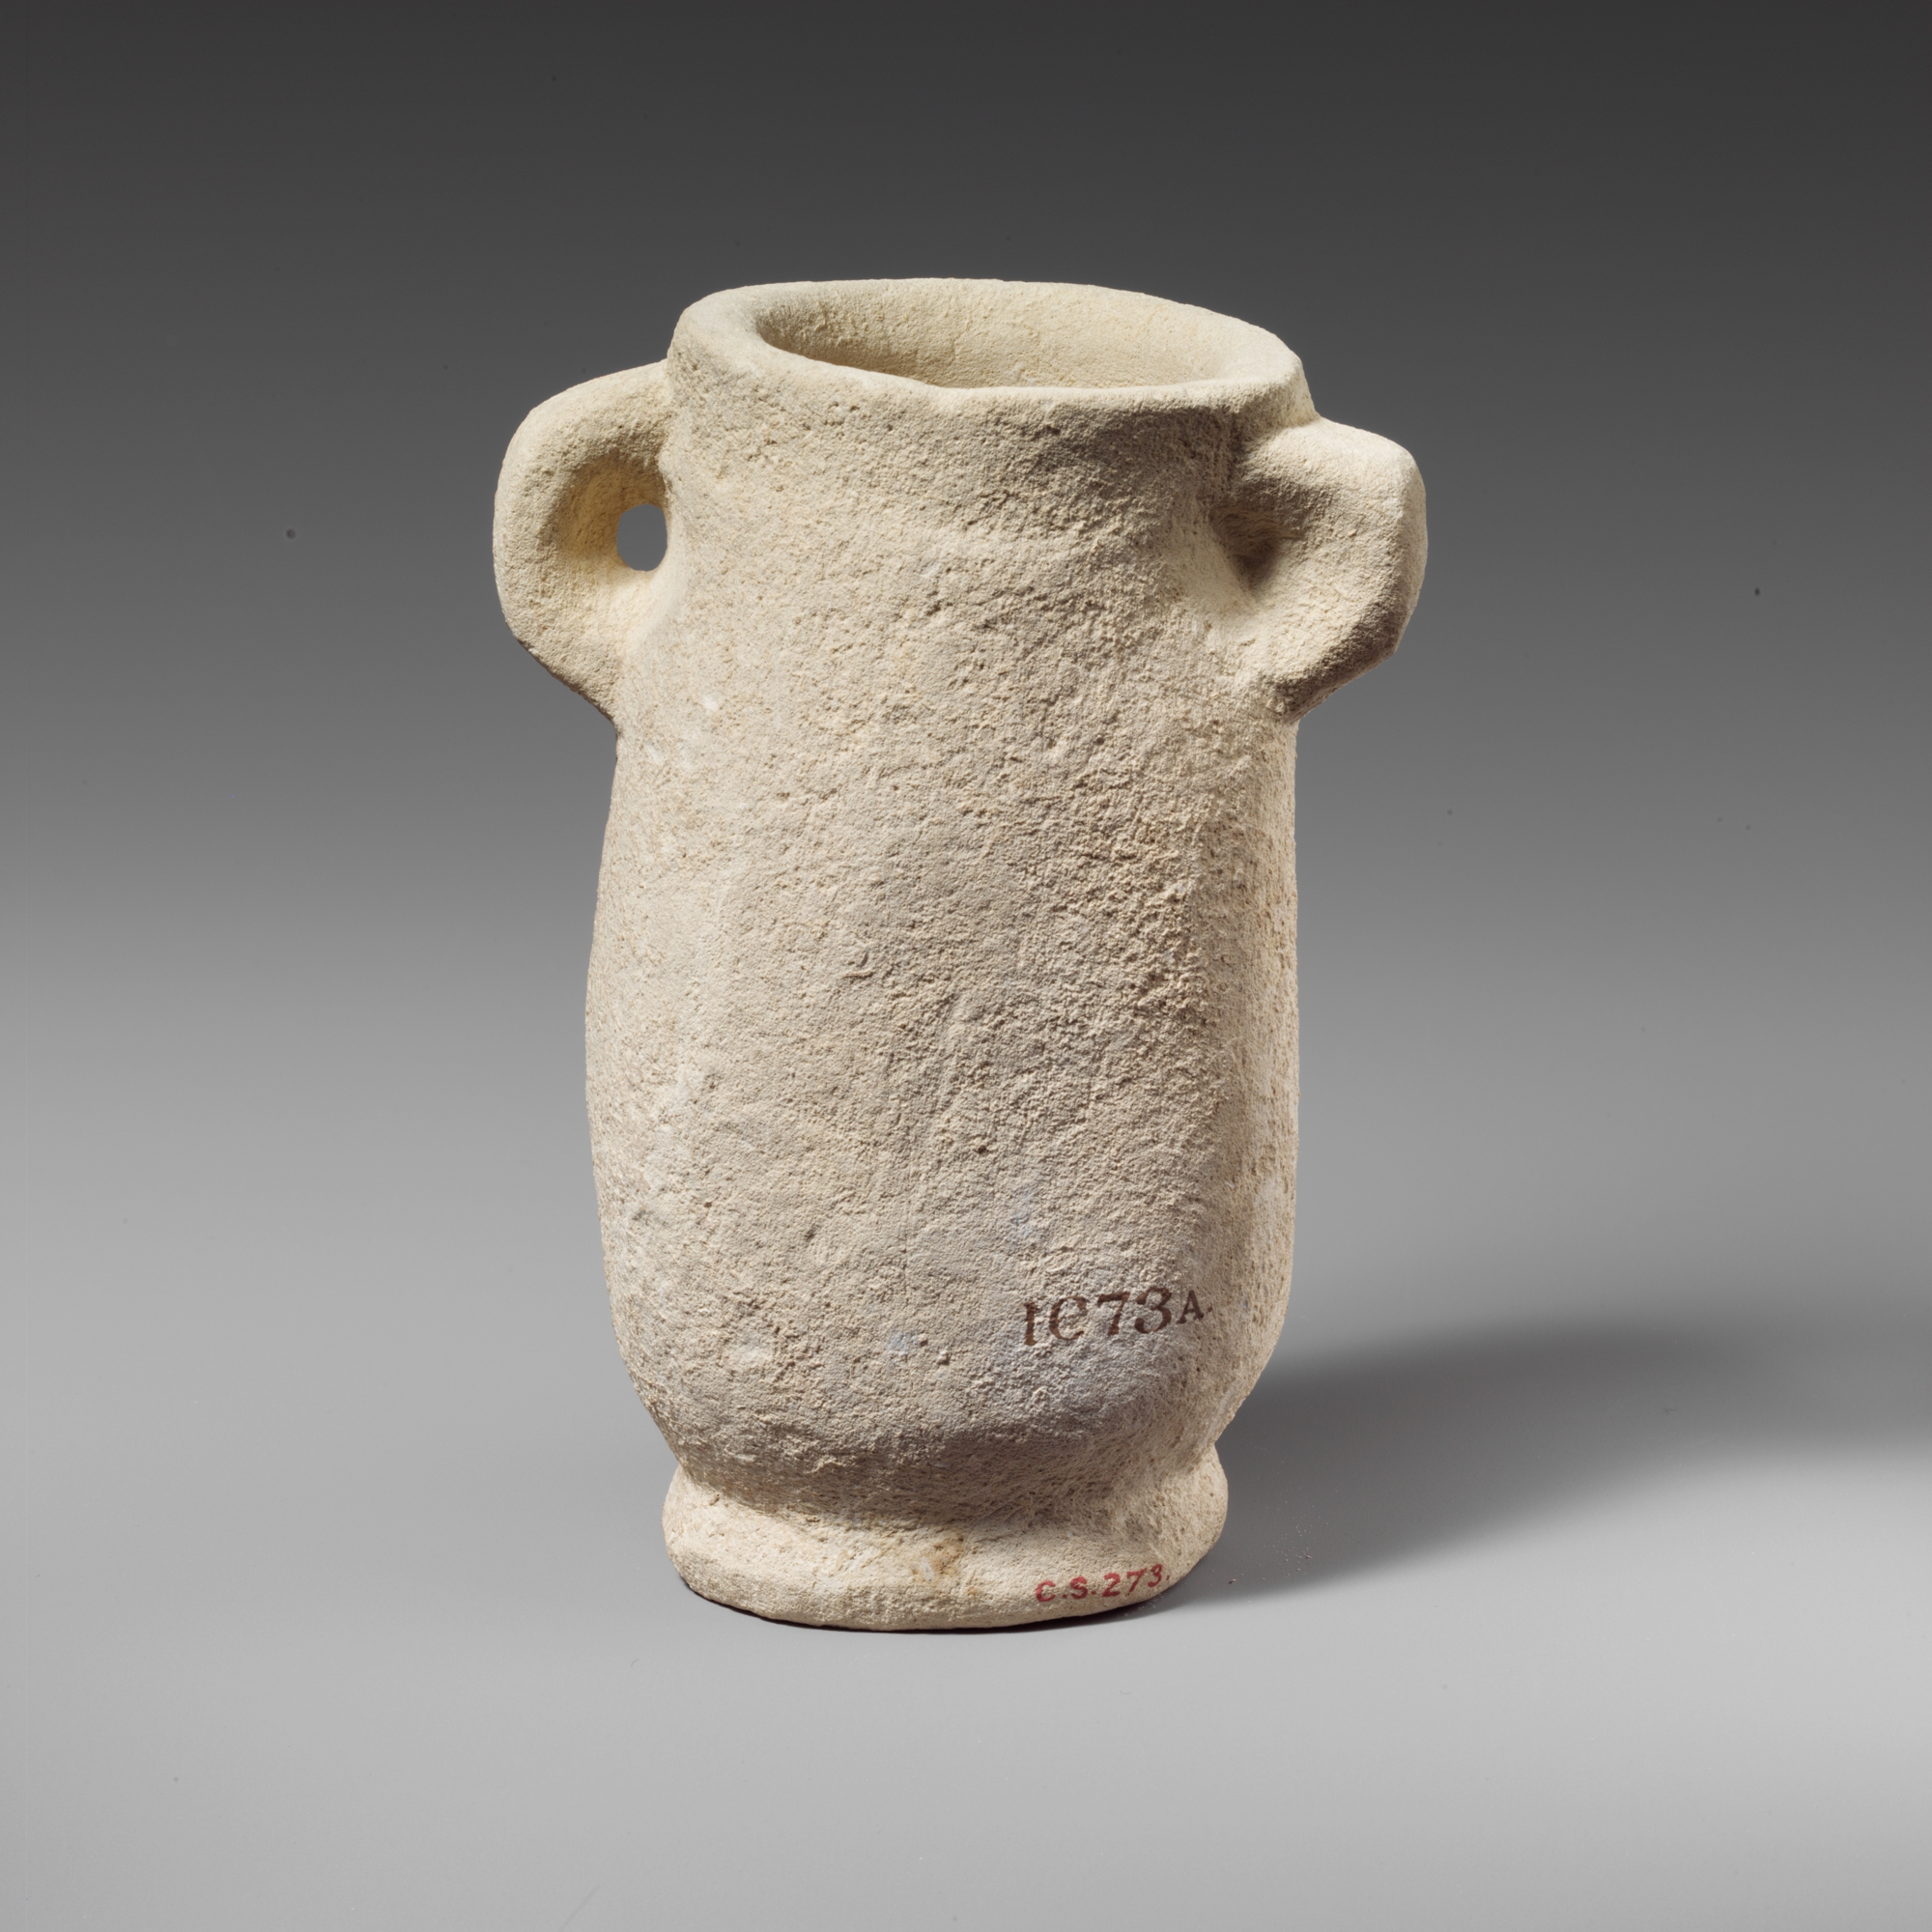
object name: jug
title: Small chalk amphora (jar)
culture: cypriot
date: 600-201 BCE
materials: chalk